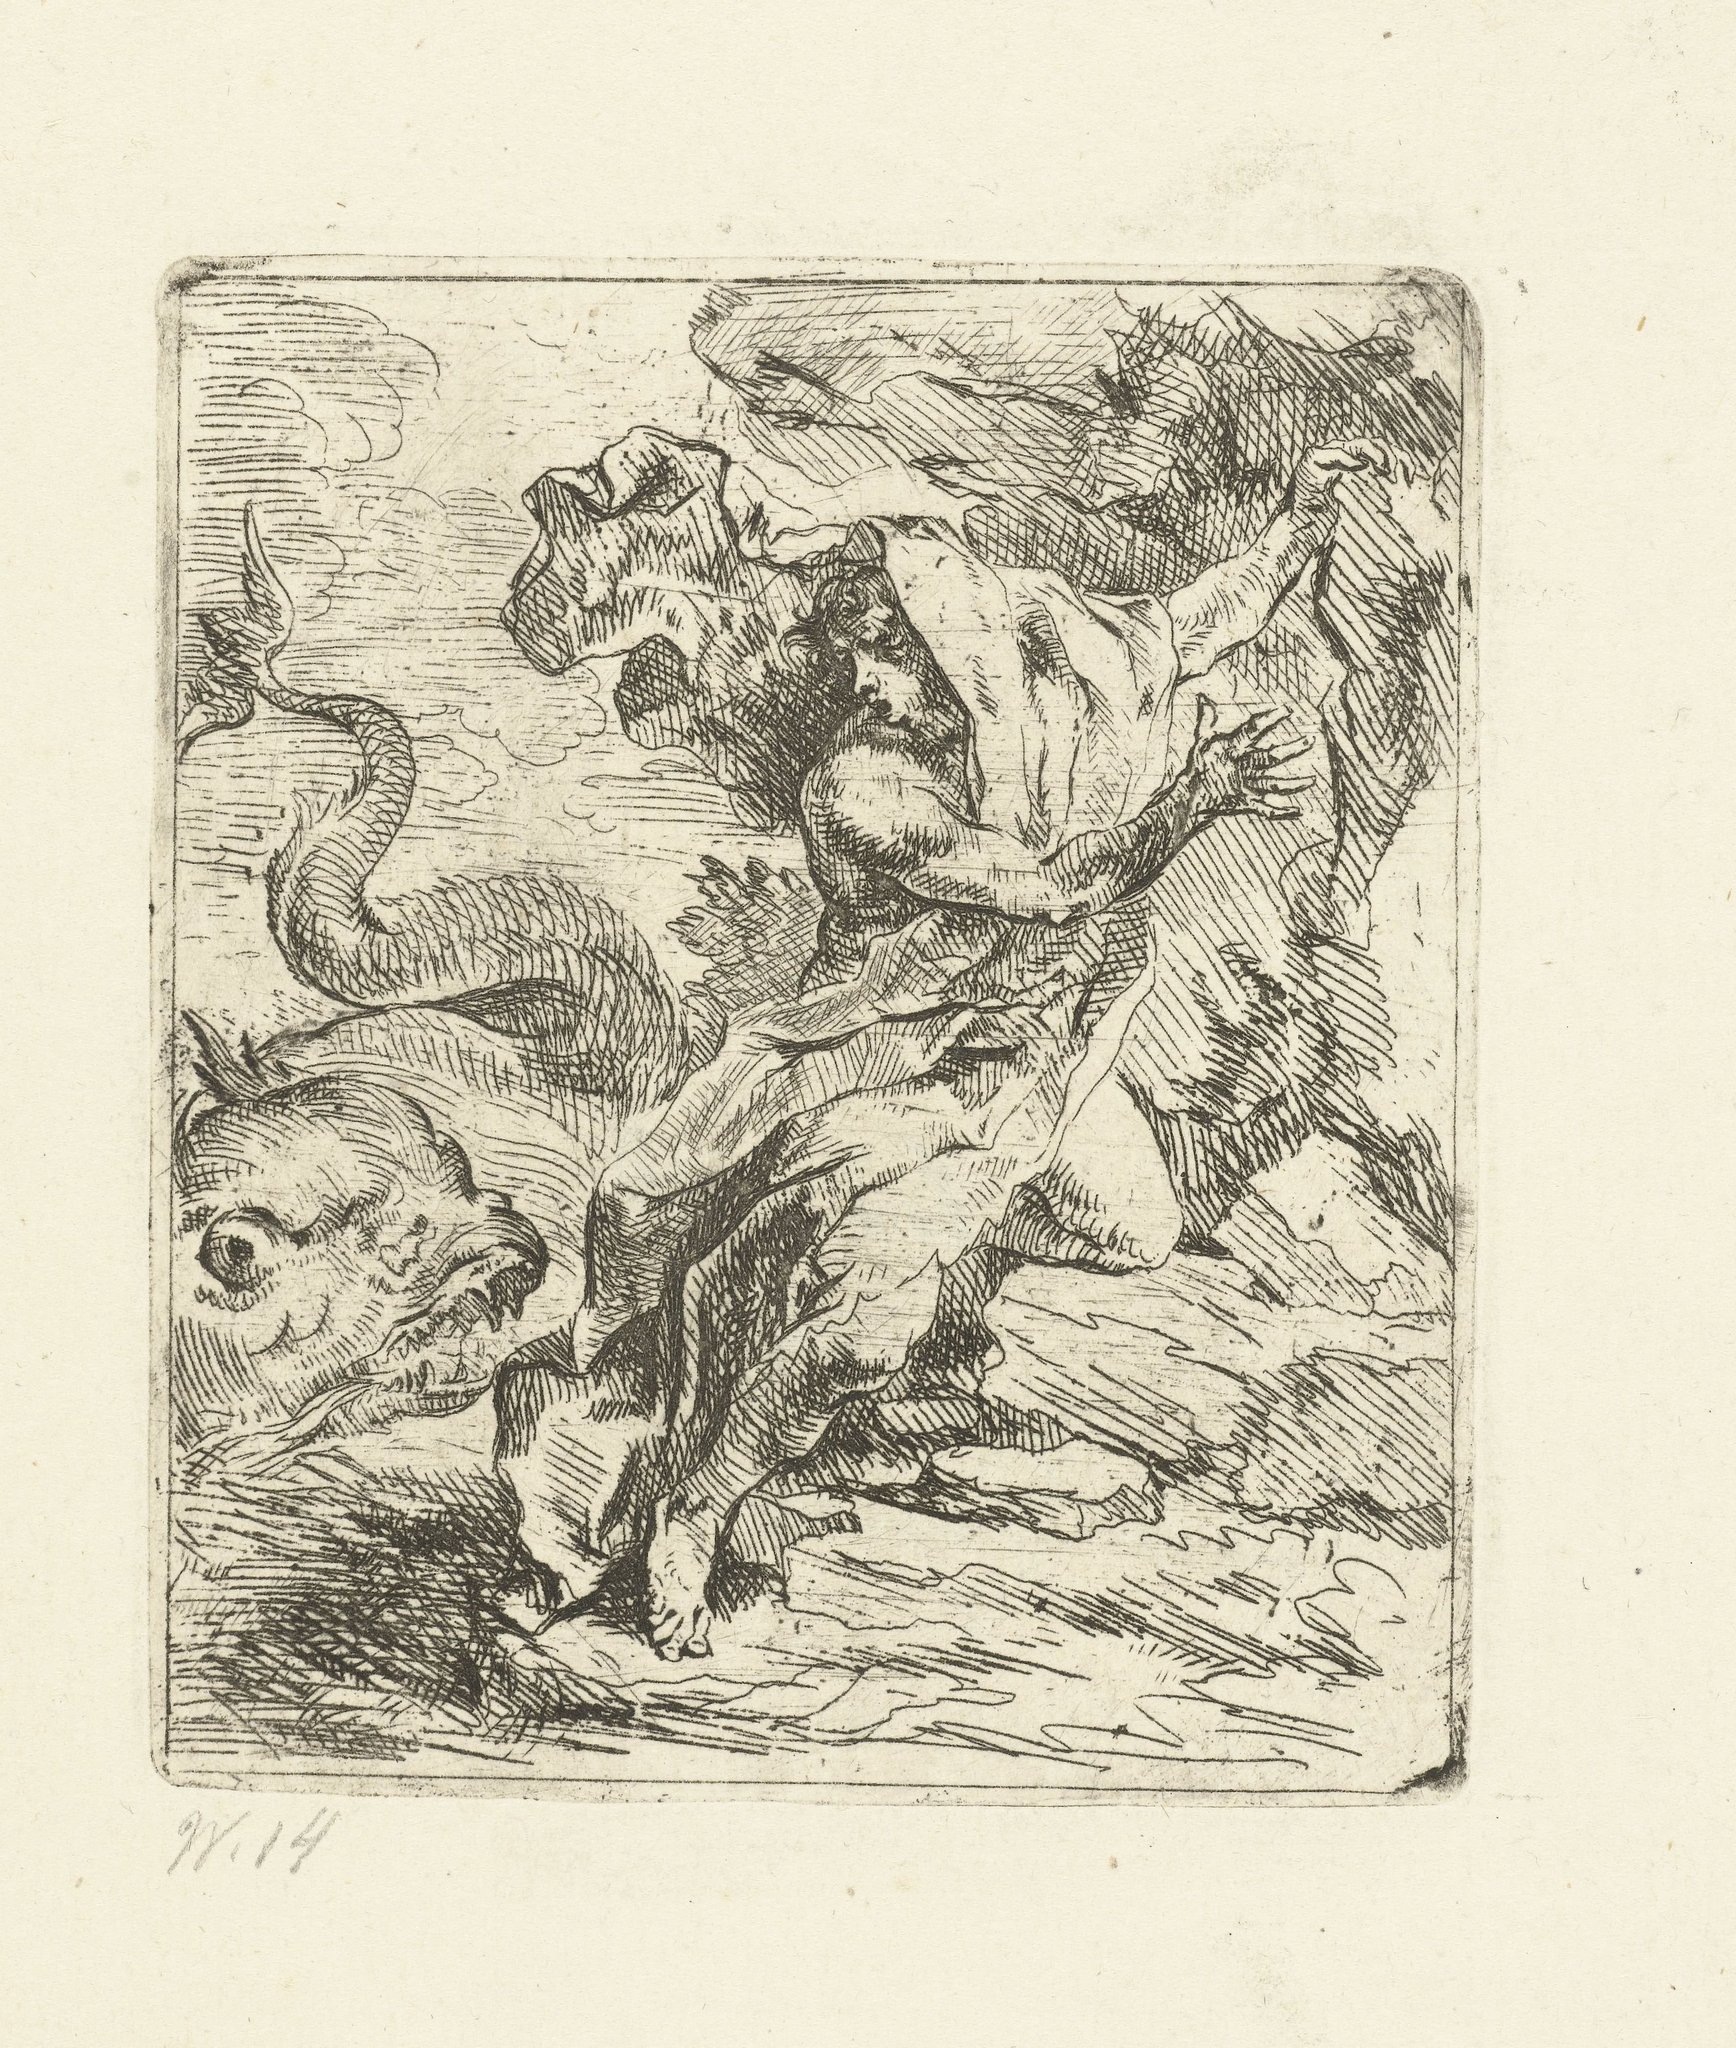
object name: print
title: Jongeman aan de kust, vluchtend voor een zeemonster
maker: louis de deyster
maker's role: draughtsman, painter, print maker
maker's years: 1656-1711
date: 1666-1711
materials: paper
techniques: etching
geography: southern netherlands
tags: flight, running away; pursuing, monsters ~ swimming mammals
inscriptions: collector's mark: Lugt 2228